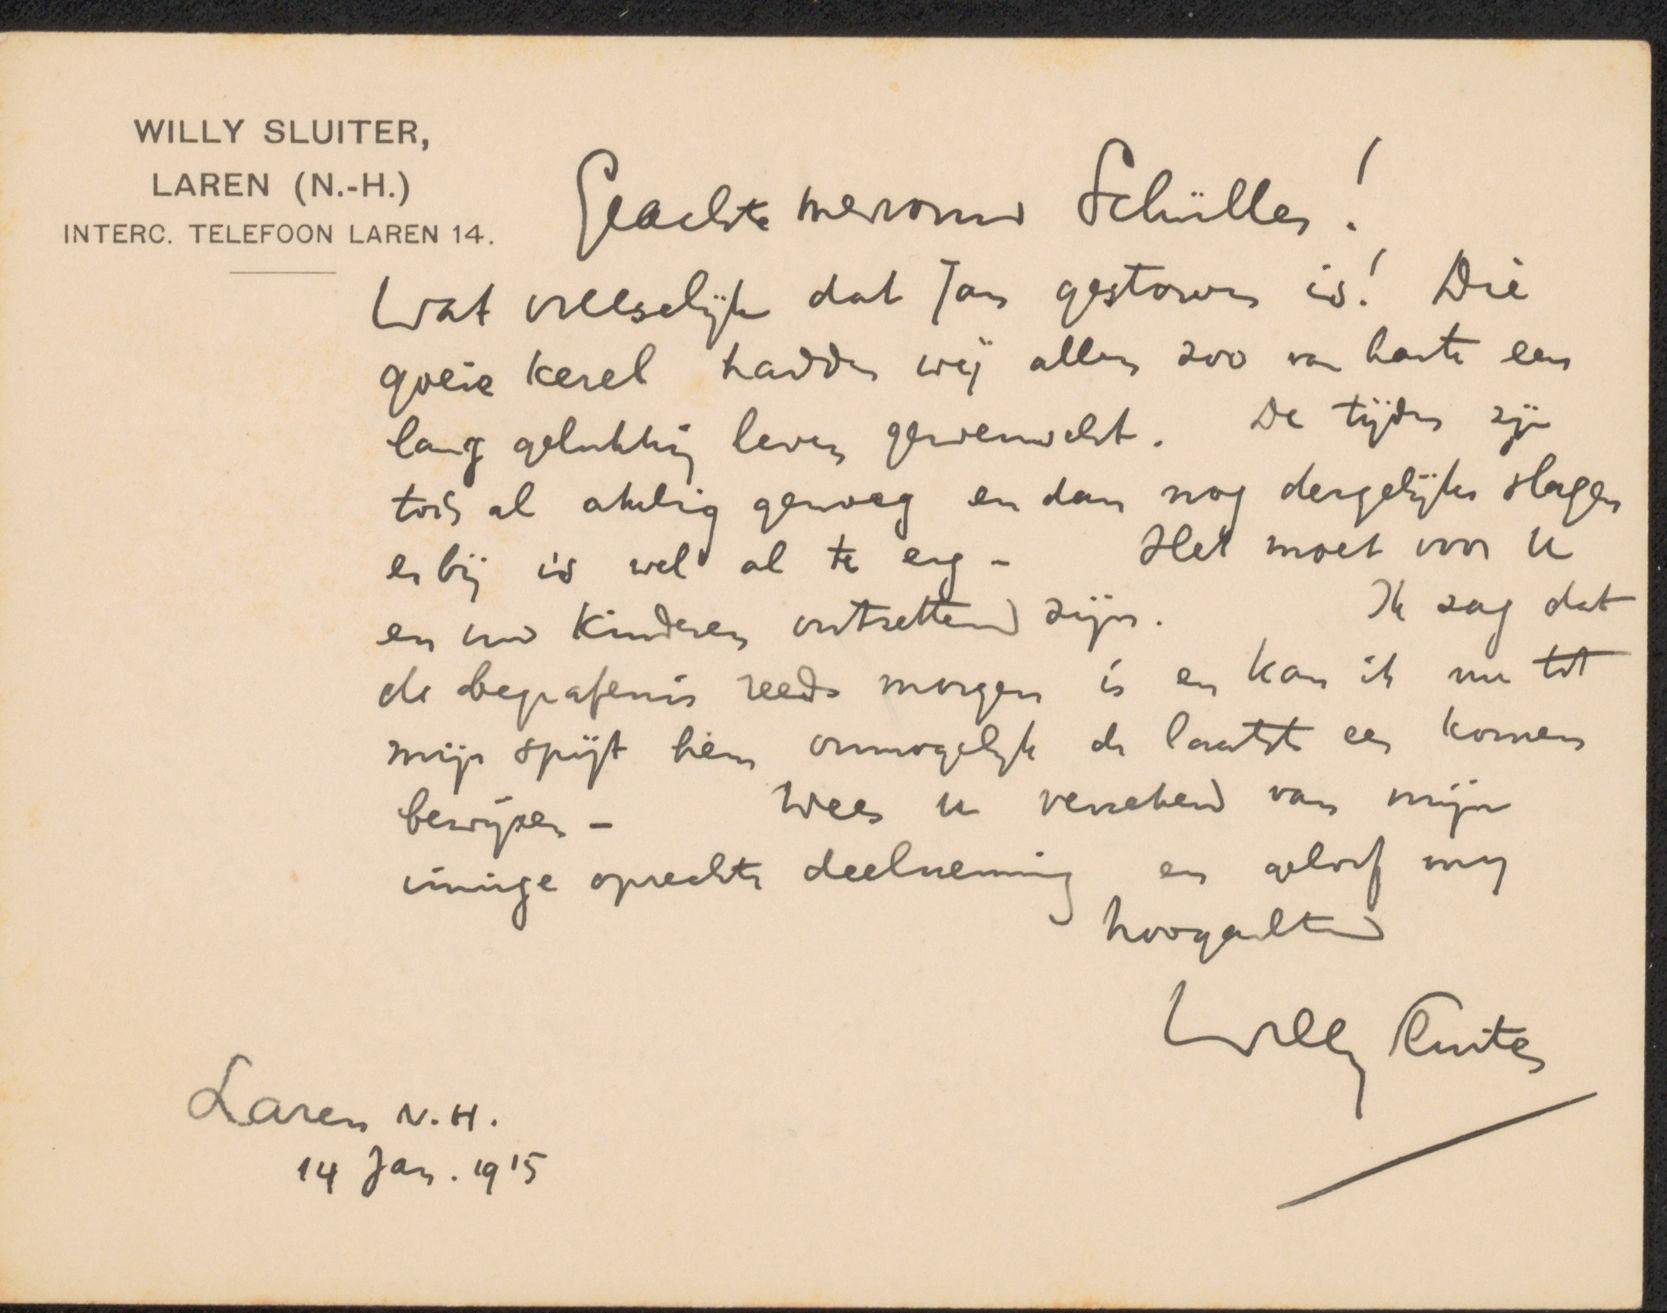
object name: letter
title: Brief aan E.H. Schüller-Audretsch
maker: willy sluiter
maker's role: draughtsman, painter, print maker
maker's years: 1873-1949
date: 1915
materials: cardboard, ink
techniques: pen, printing, writing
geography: laren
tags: jan schüller, family life